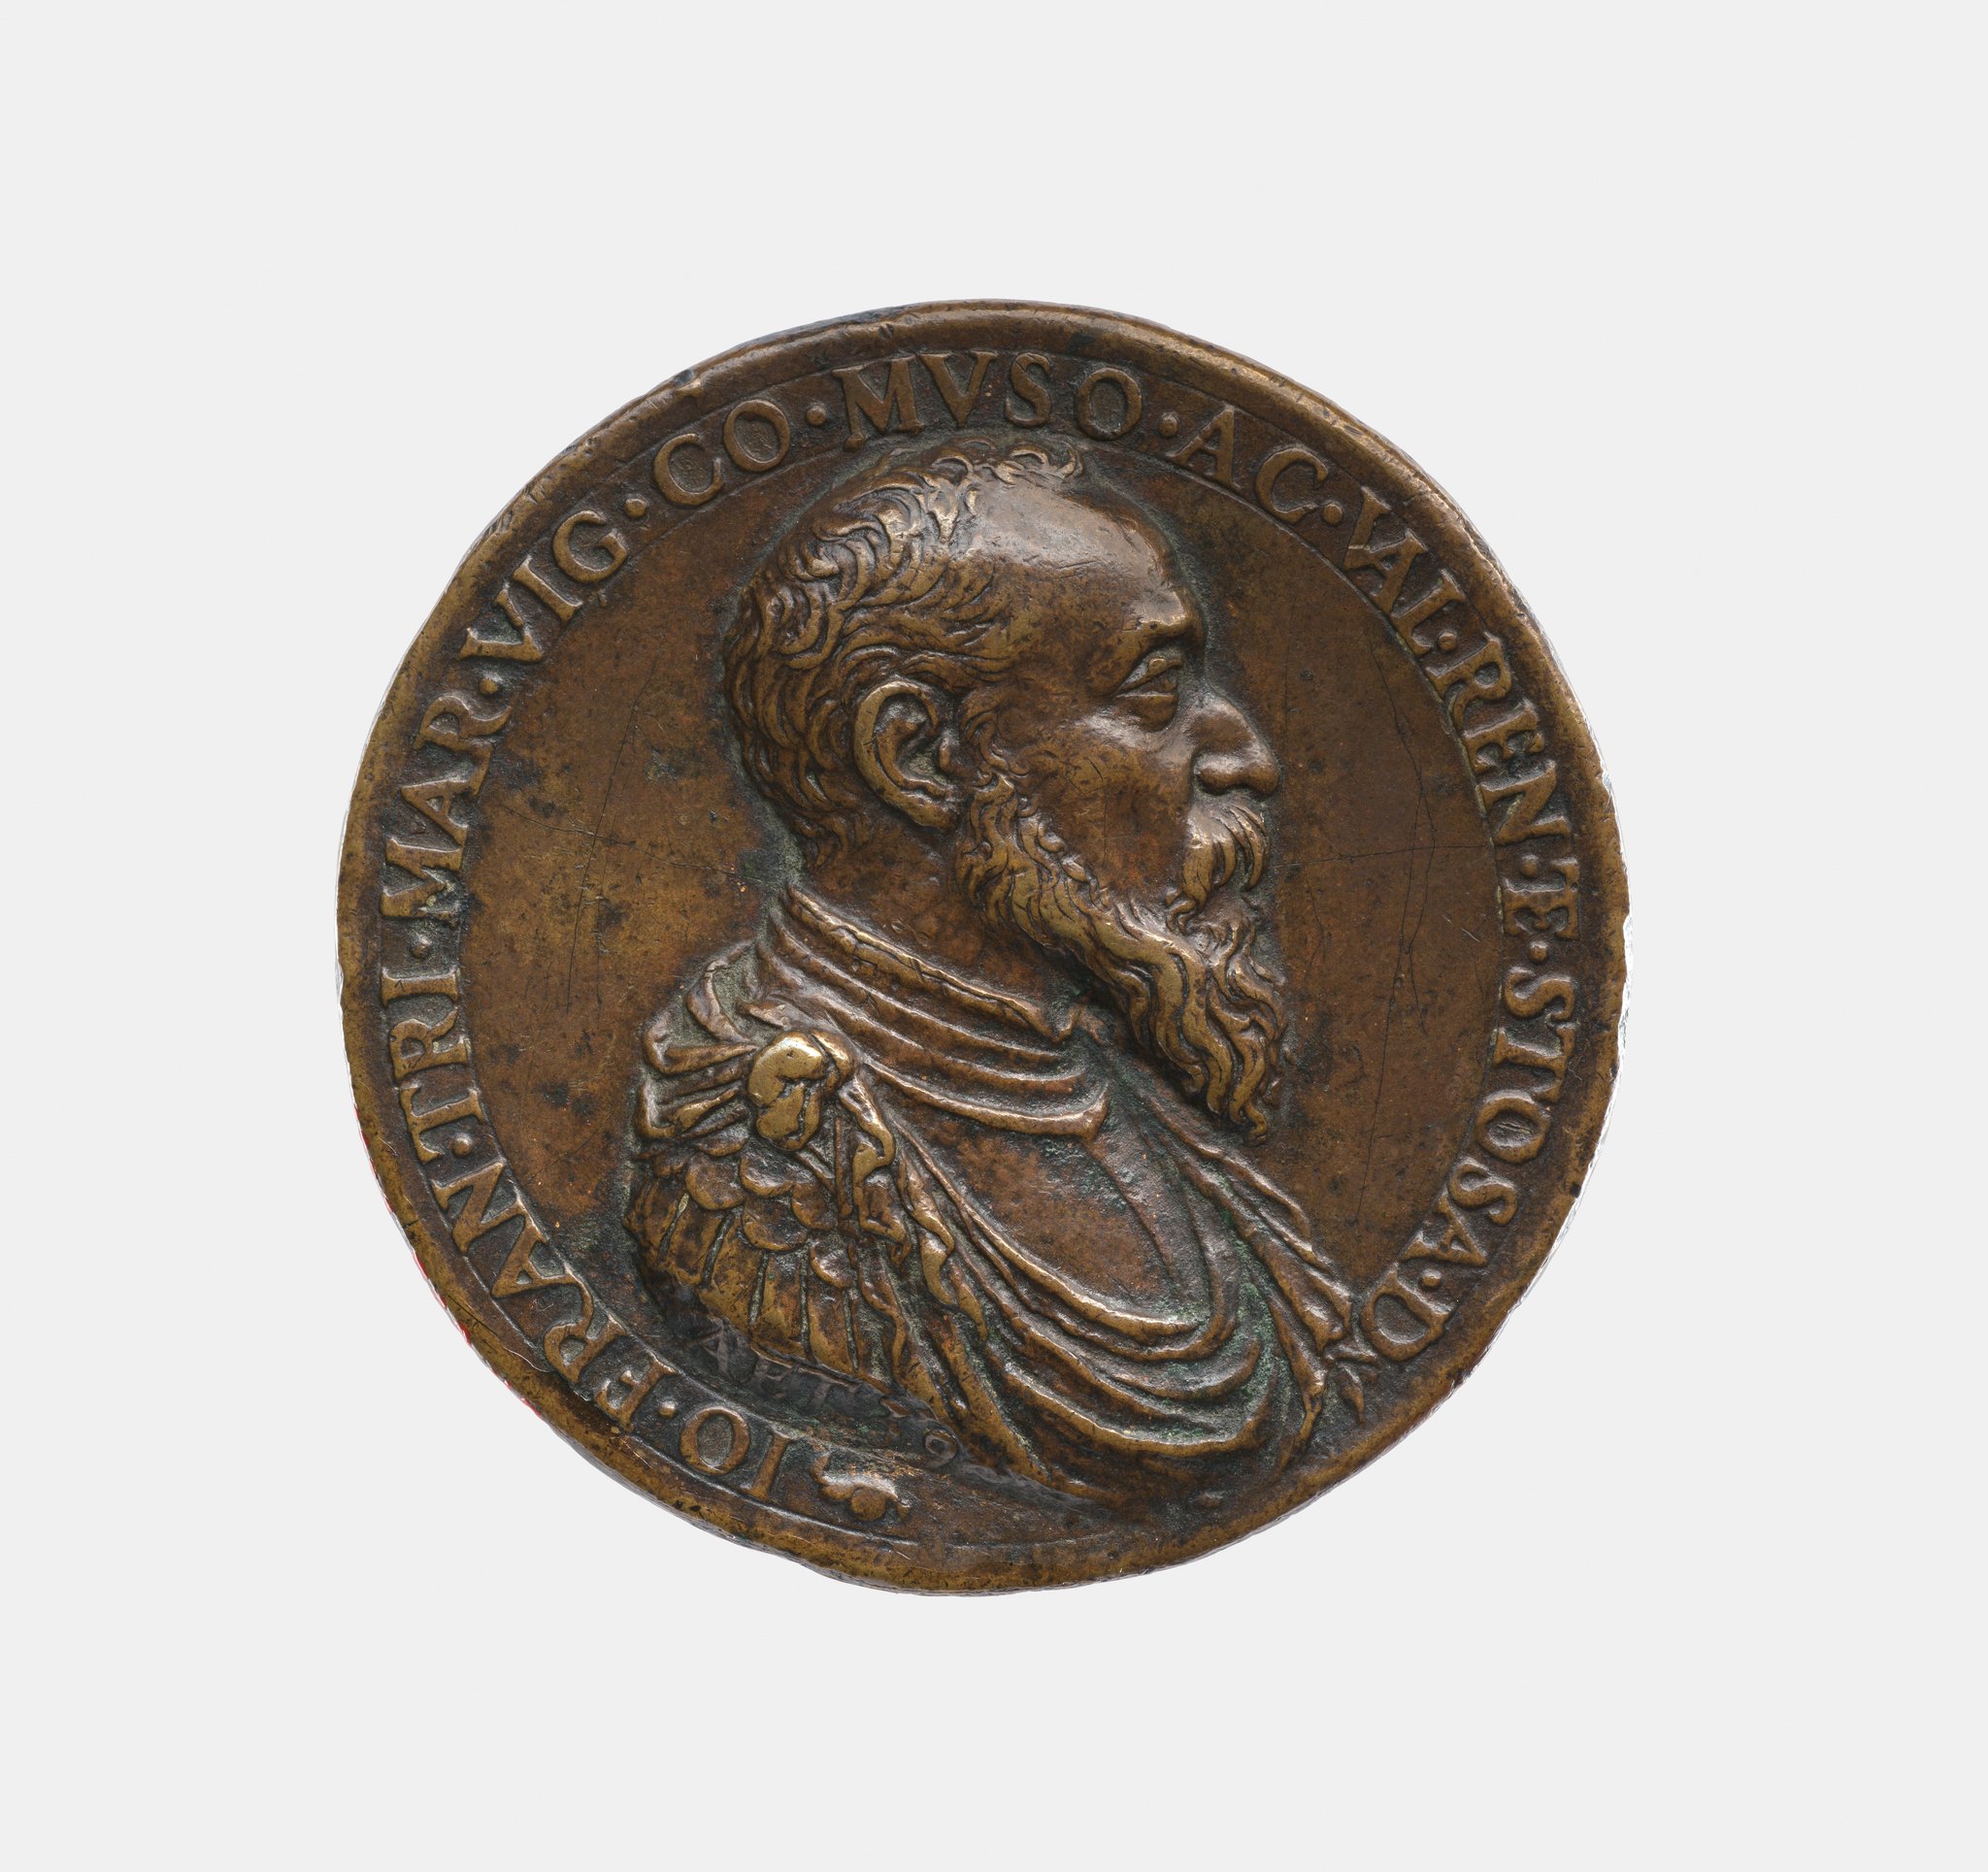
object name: medal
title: Gianfrancesco Trivulzio 1504-73, Marchese of Vigevano, Count of Mesocco 1518-49, Rheinwald and Stoss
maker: pietro paolo galeotti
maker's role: artist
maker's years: 1500-1600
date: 1543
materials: bronze